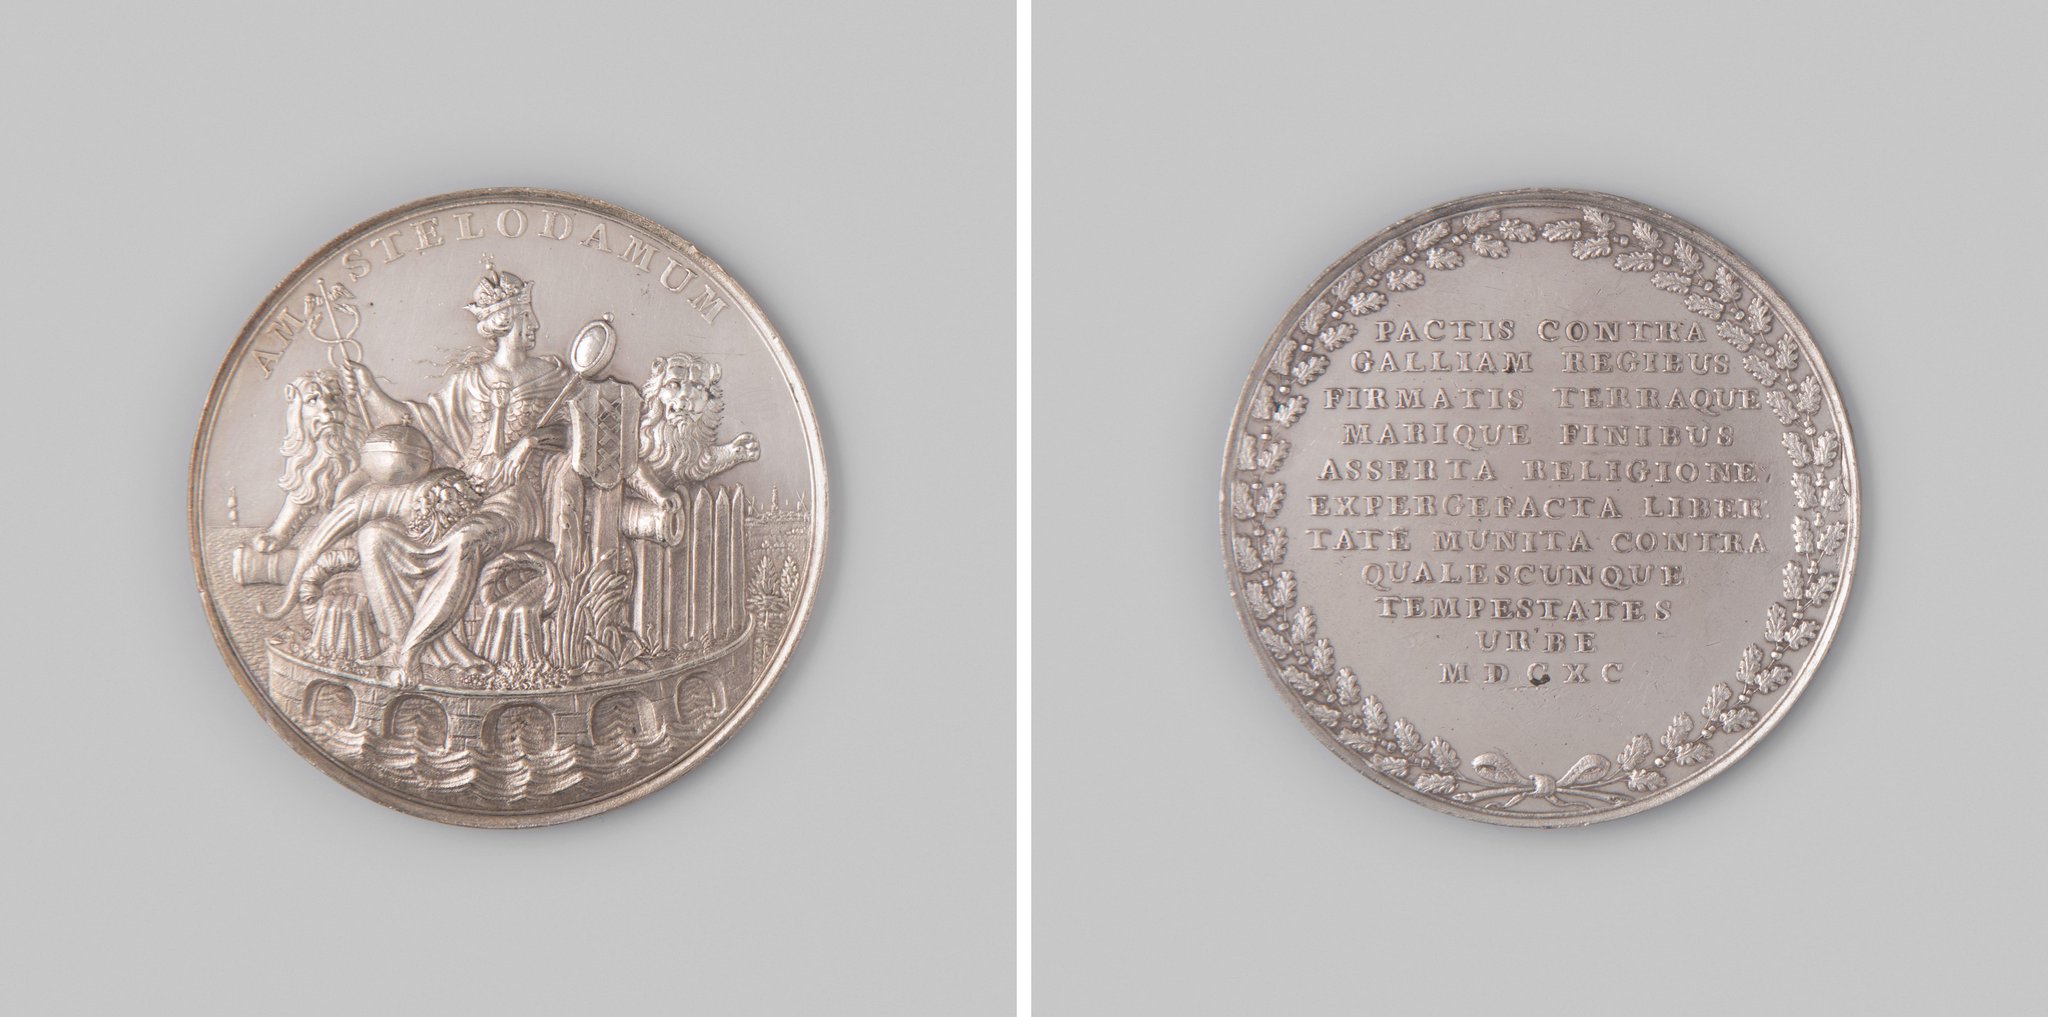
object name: history medal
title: Voltooiing van de stenen schutsluizen en waterkeringen te Amsterdam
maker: Anonymous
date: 1690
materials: silver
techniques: striking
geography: netherlands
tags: amsterdam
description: Zilveren penning. Voorzijde: Amsterdam in gedaante van gekroonde maagd met Mercuriusstaf, spiegel, rijksappel en wapenschild zittend tussen twee leeuwen en twee waterkruiken binnen omschrift. Keerzijde: opschrift binnen eikenkrans